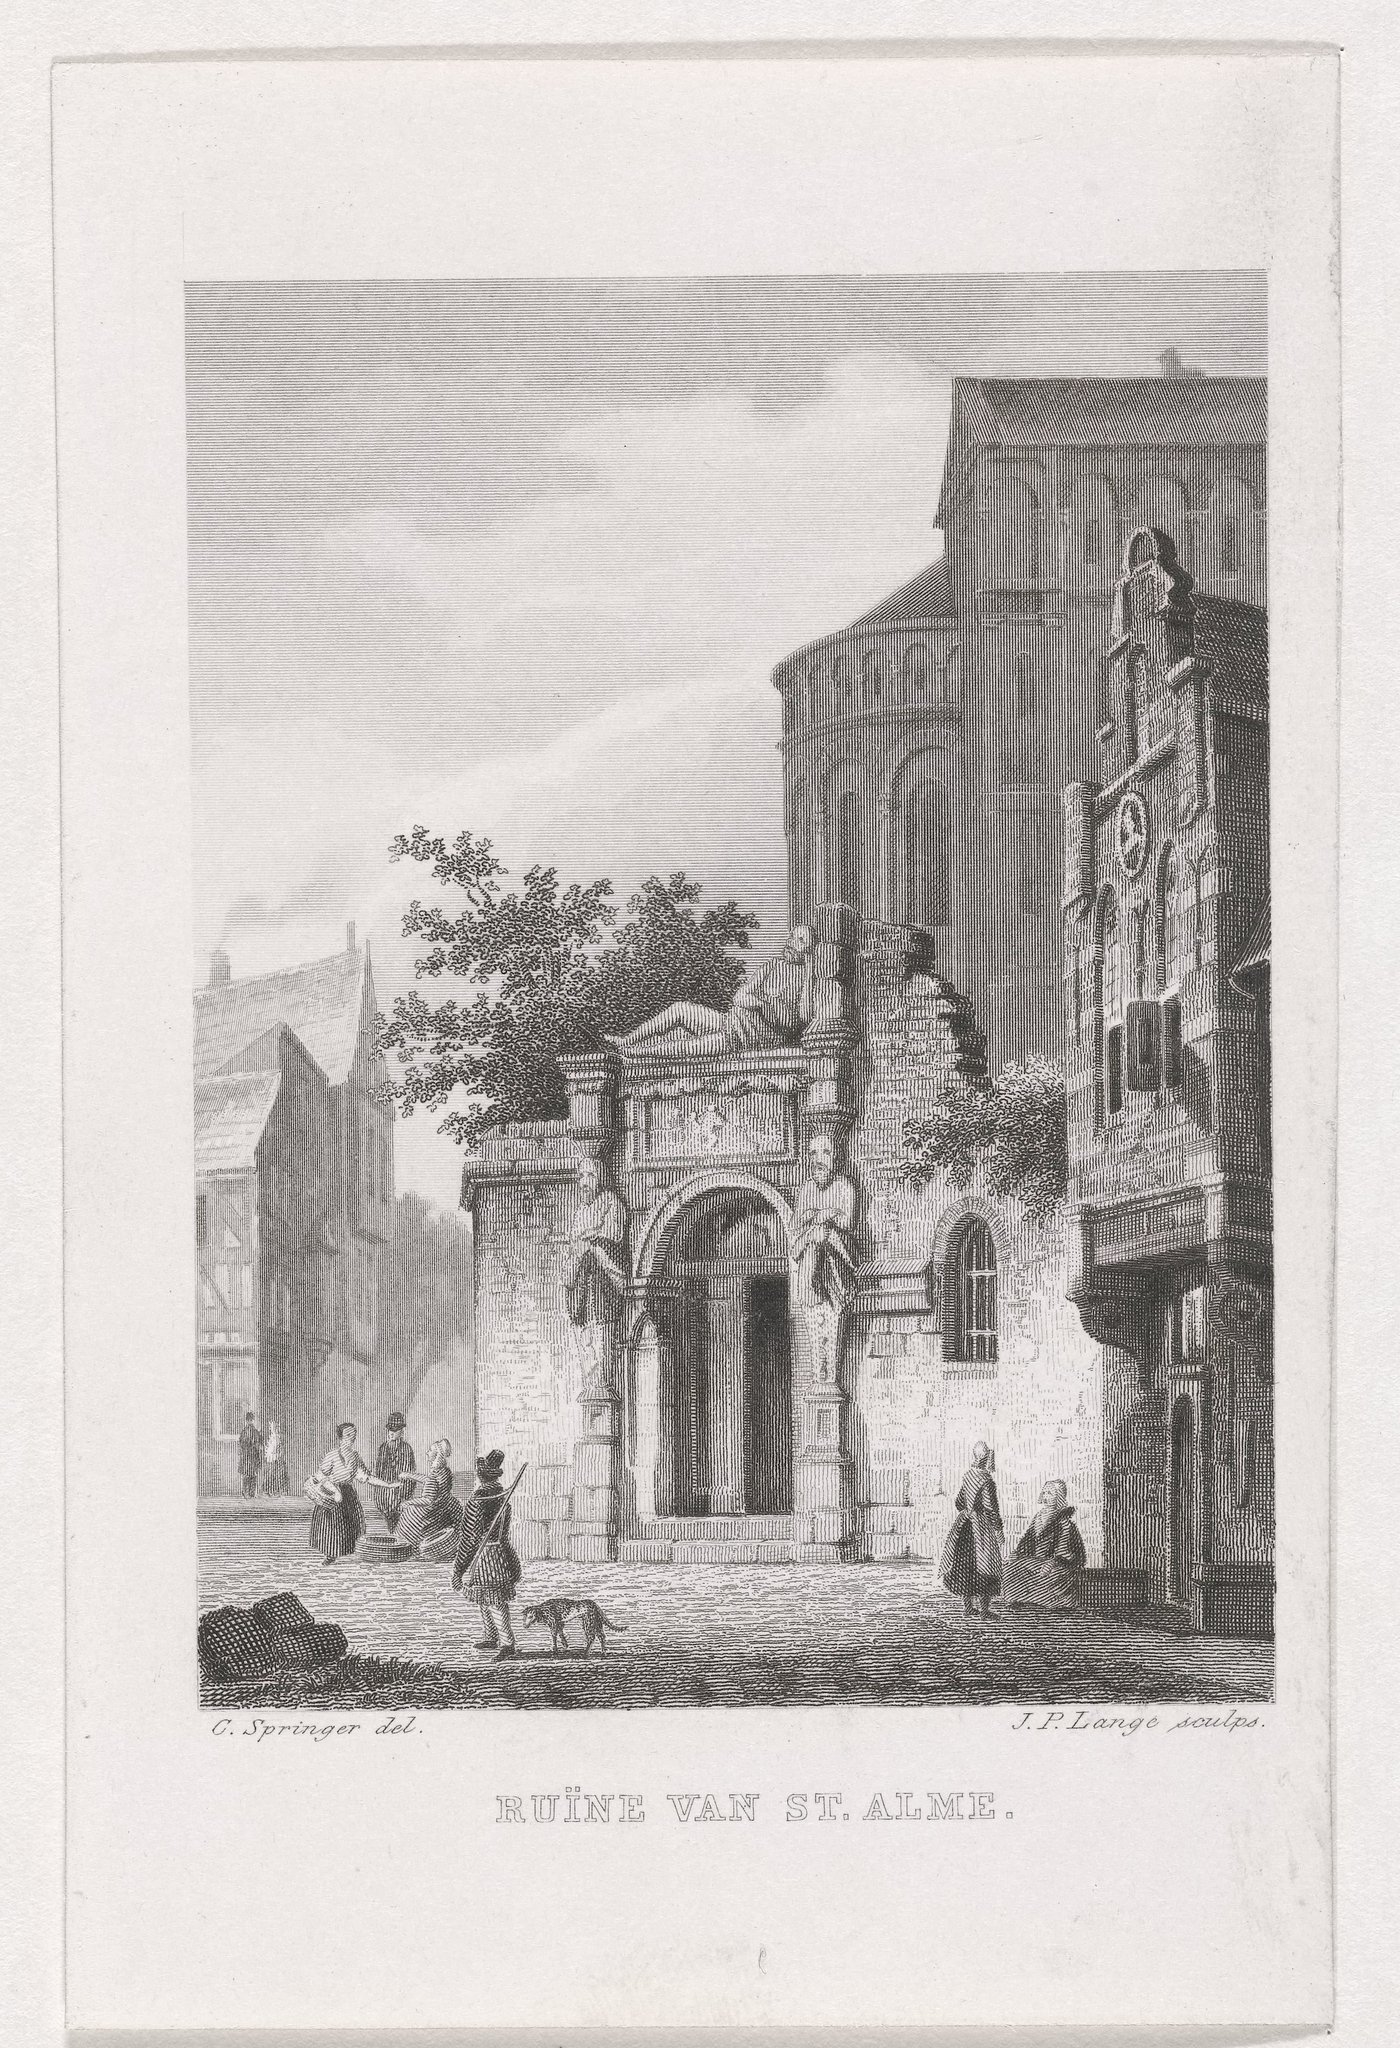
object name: print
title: Ruïne van St. Alme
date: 1849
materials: paper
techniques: engraving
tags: gate, entrance, street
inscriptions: collector's mark: Lugt 2228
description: Gezicht op een straat met figuren, rechts een afgebrokkelde poort met zuilfiguren. Op de achtergrond een kerk.